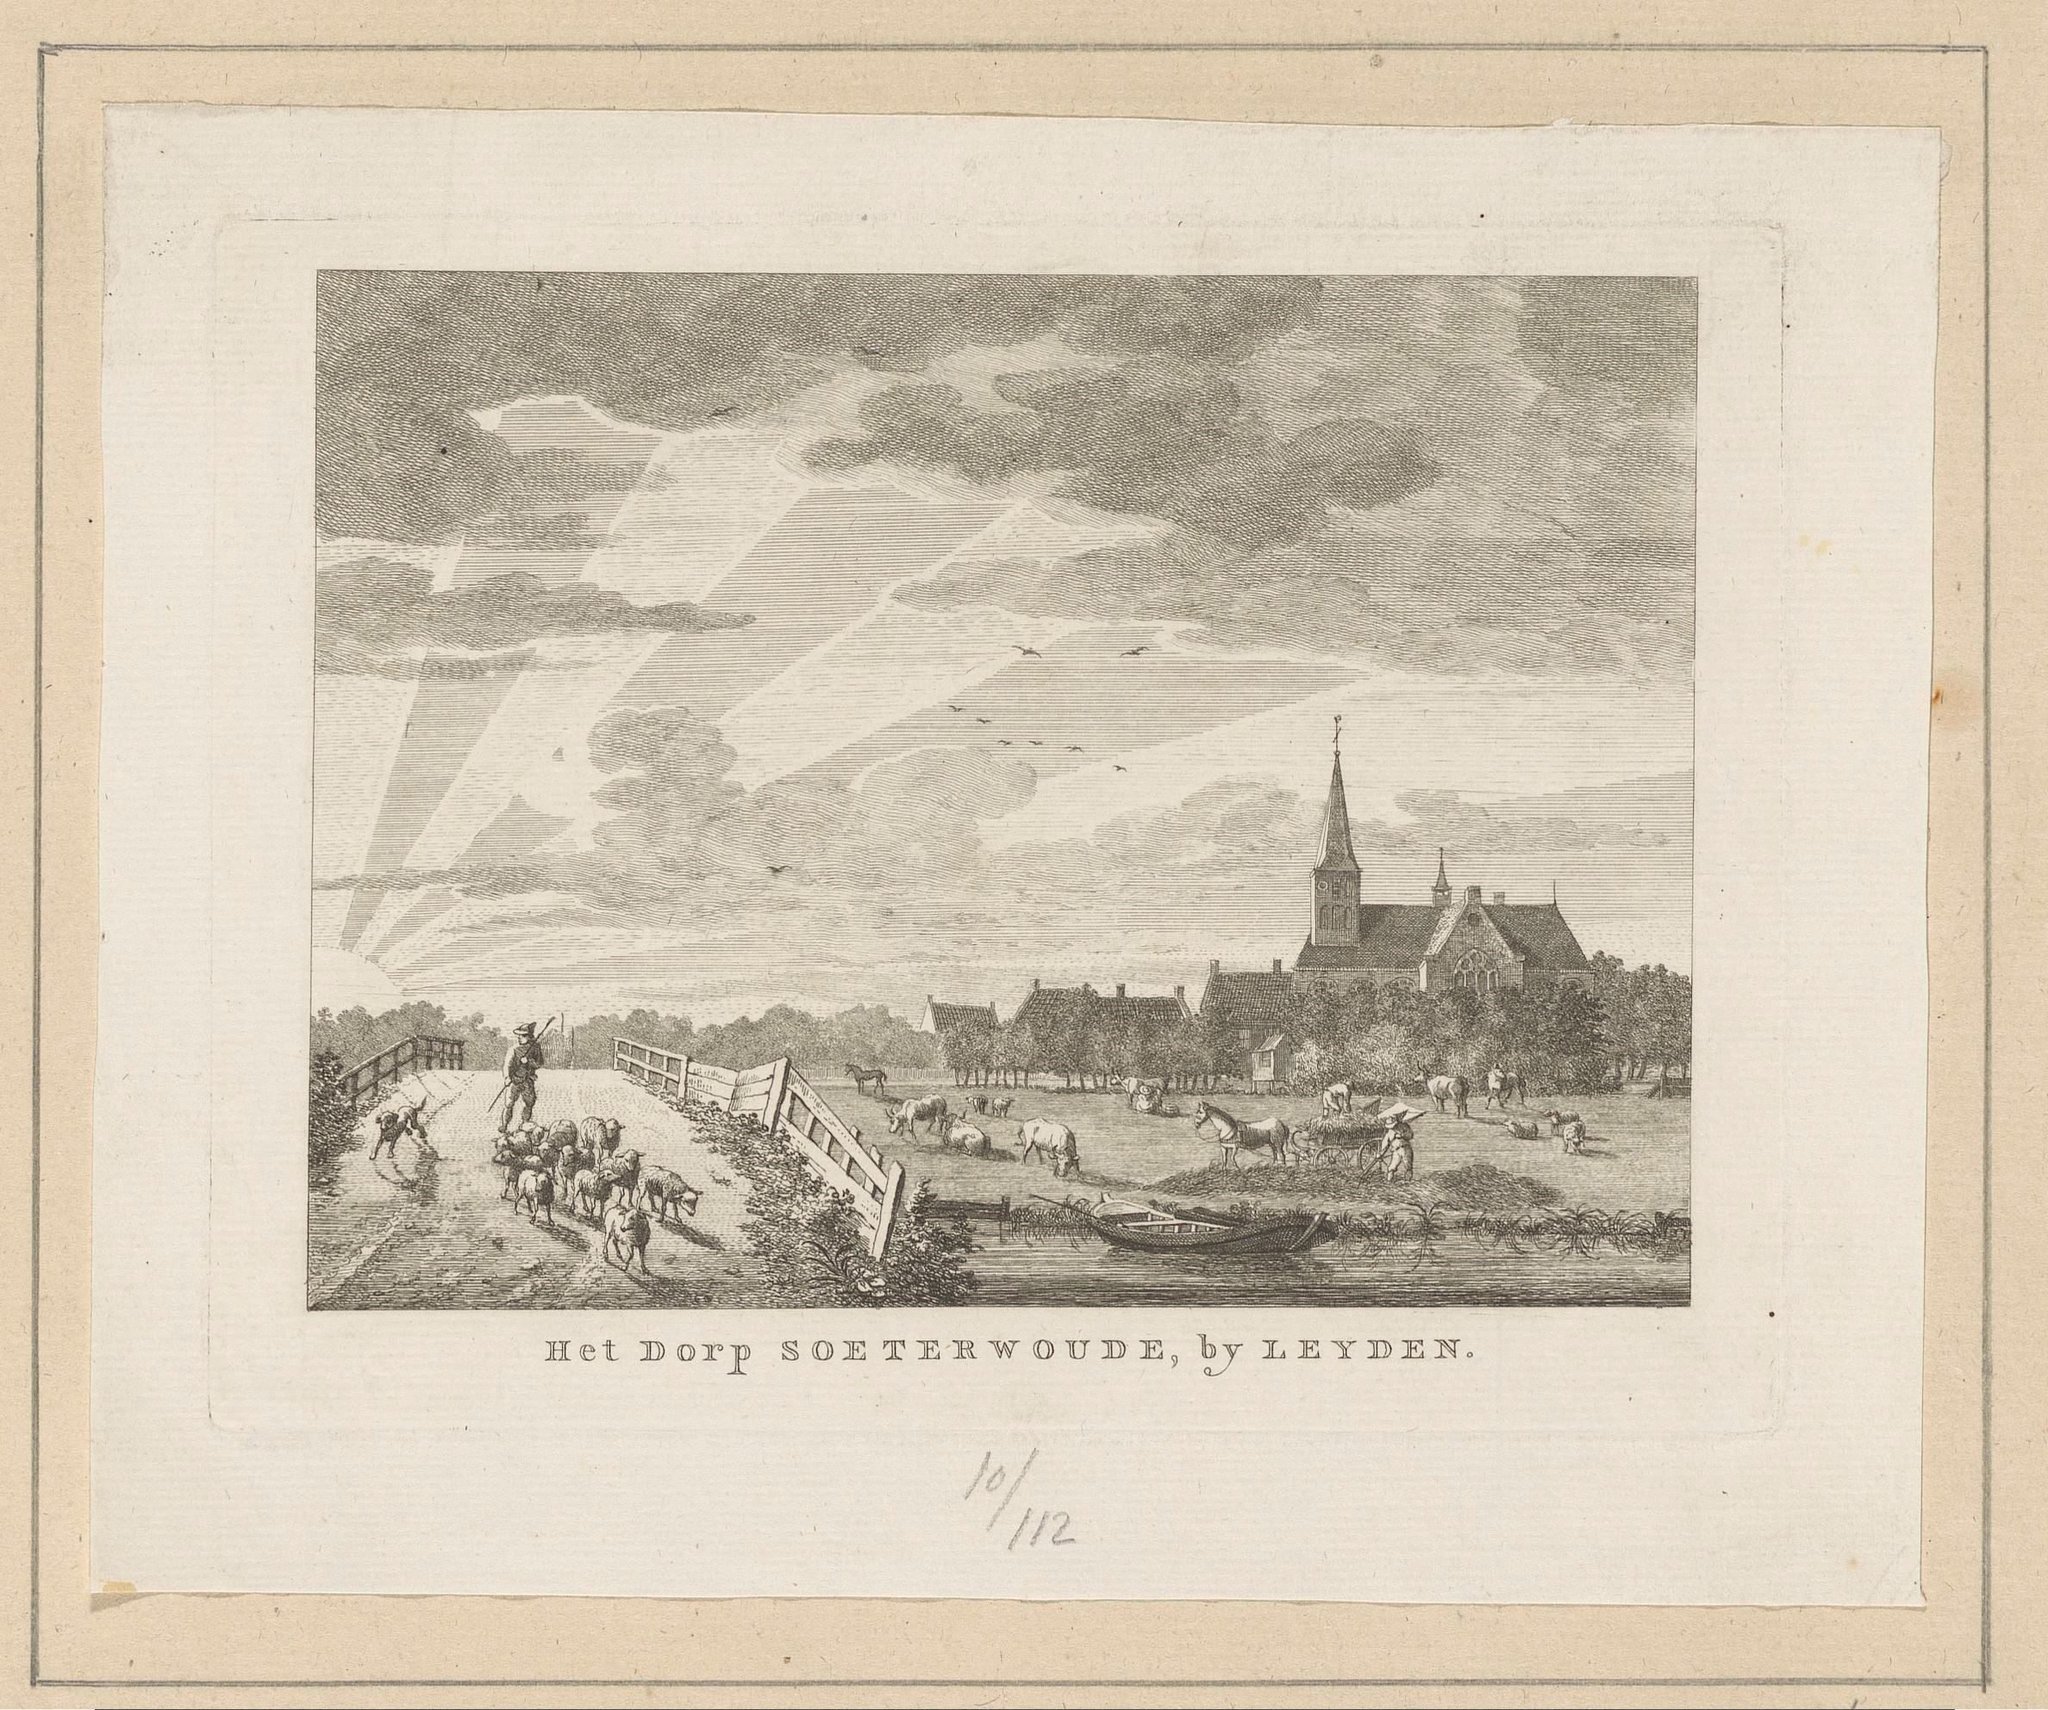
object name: print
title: Gezicht op het dorp Zoeterwoude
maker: Anonymous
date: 1750-1799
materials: paper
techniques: engraving, etching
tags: prospect of village, silhouette of village, church (exterior)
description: Gezicht op het dorp Zoeterwoude, met rechts de kerk.